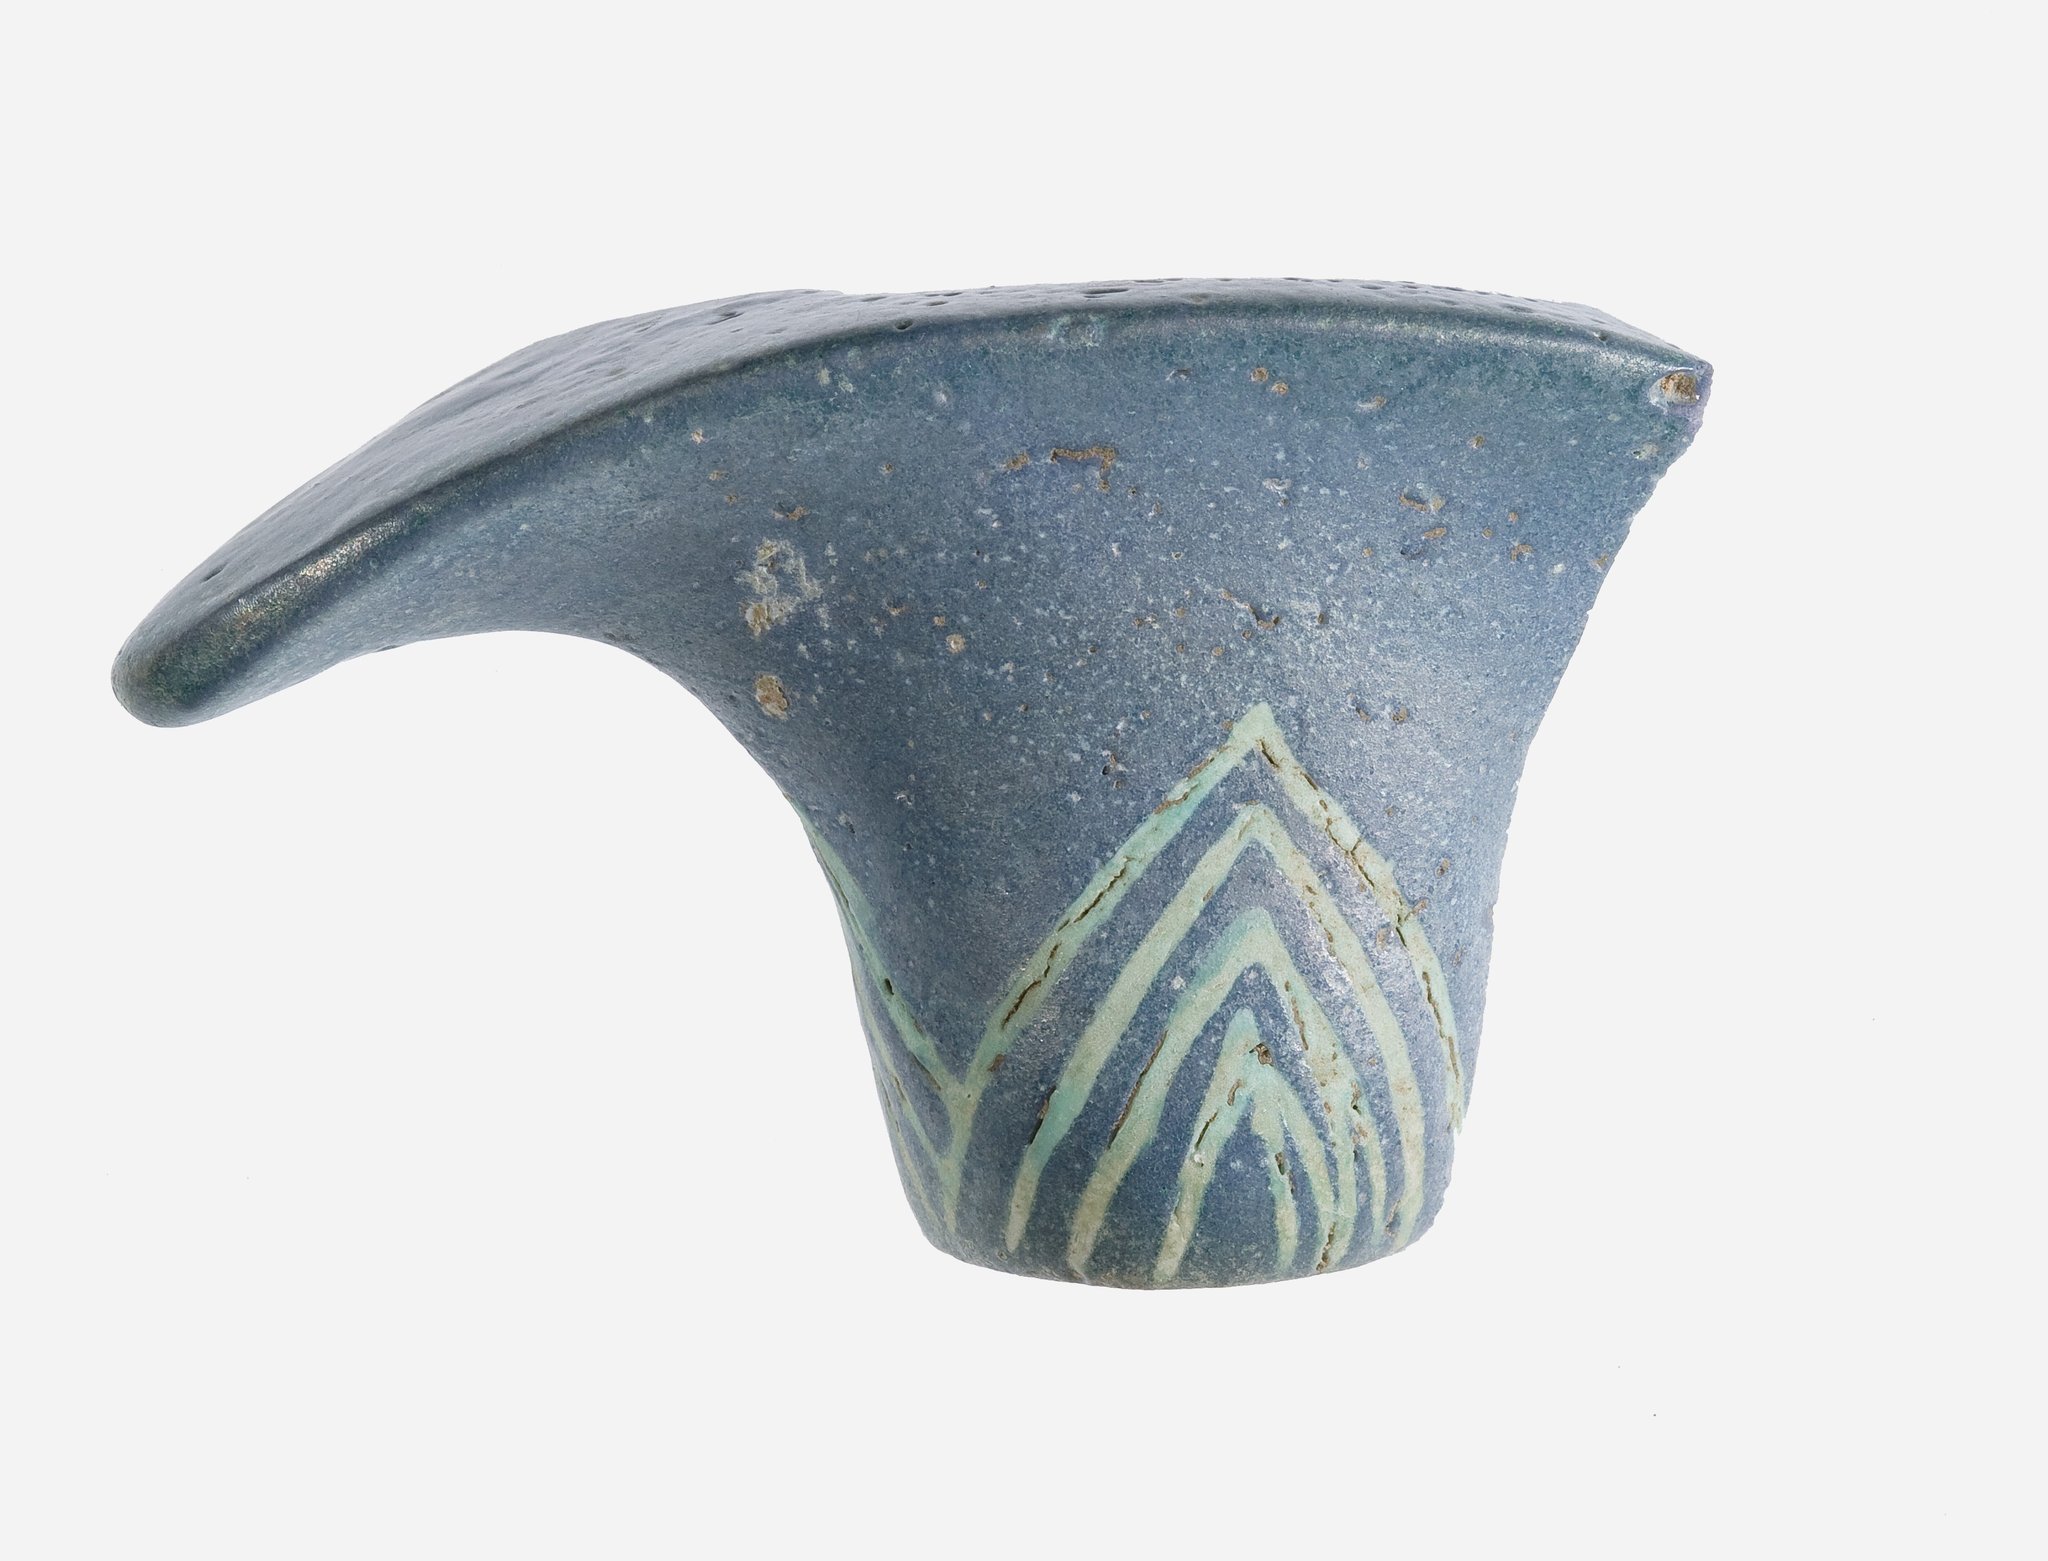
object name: mirror handle, papyrus umbel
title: Top of a Papyrus Stalk Mirror Handle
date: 1390-1352 BCE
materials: faience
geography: egypt